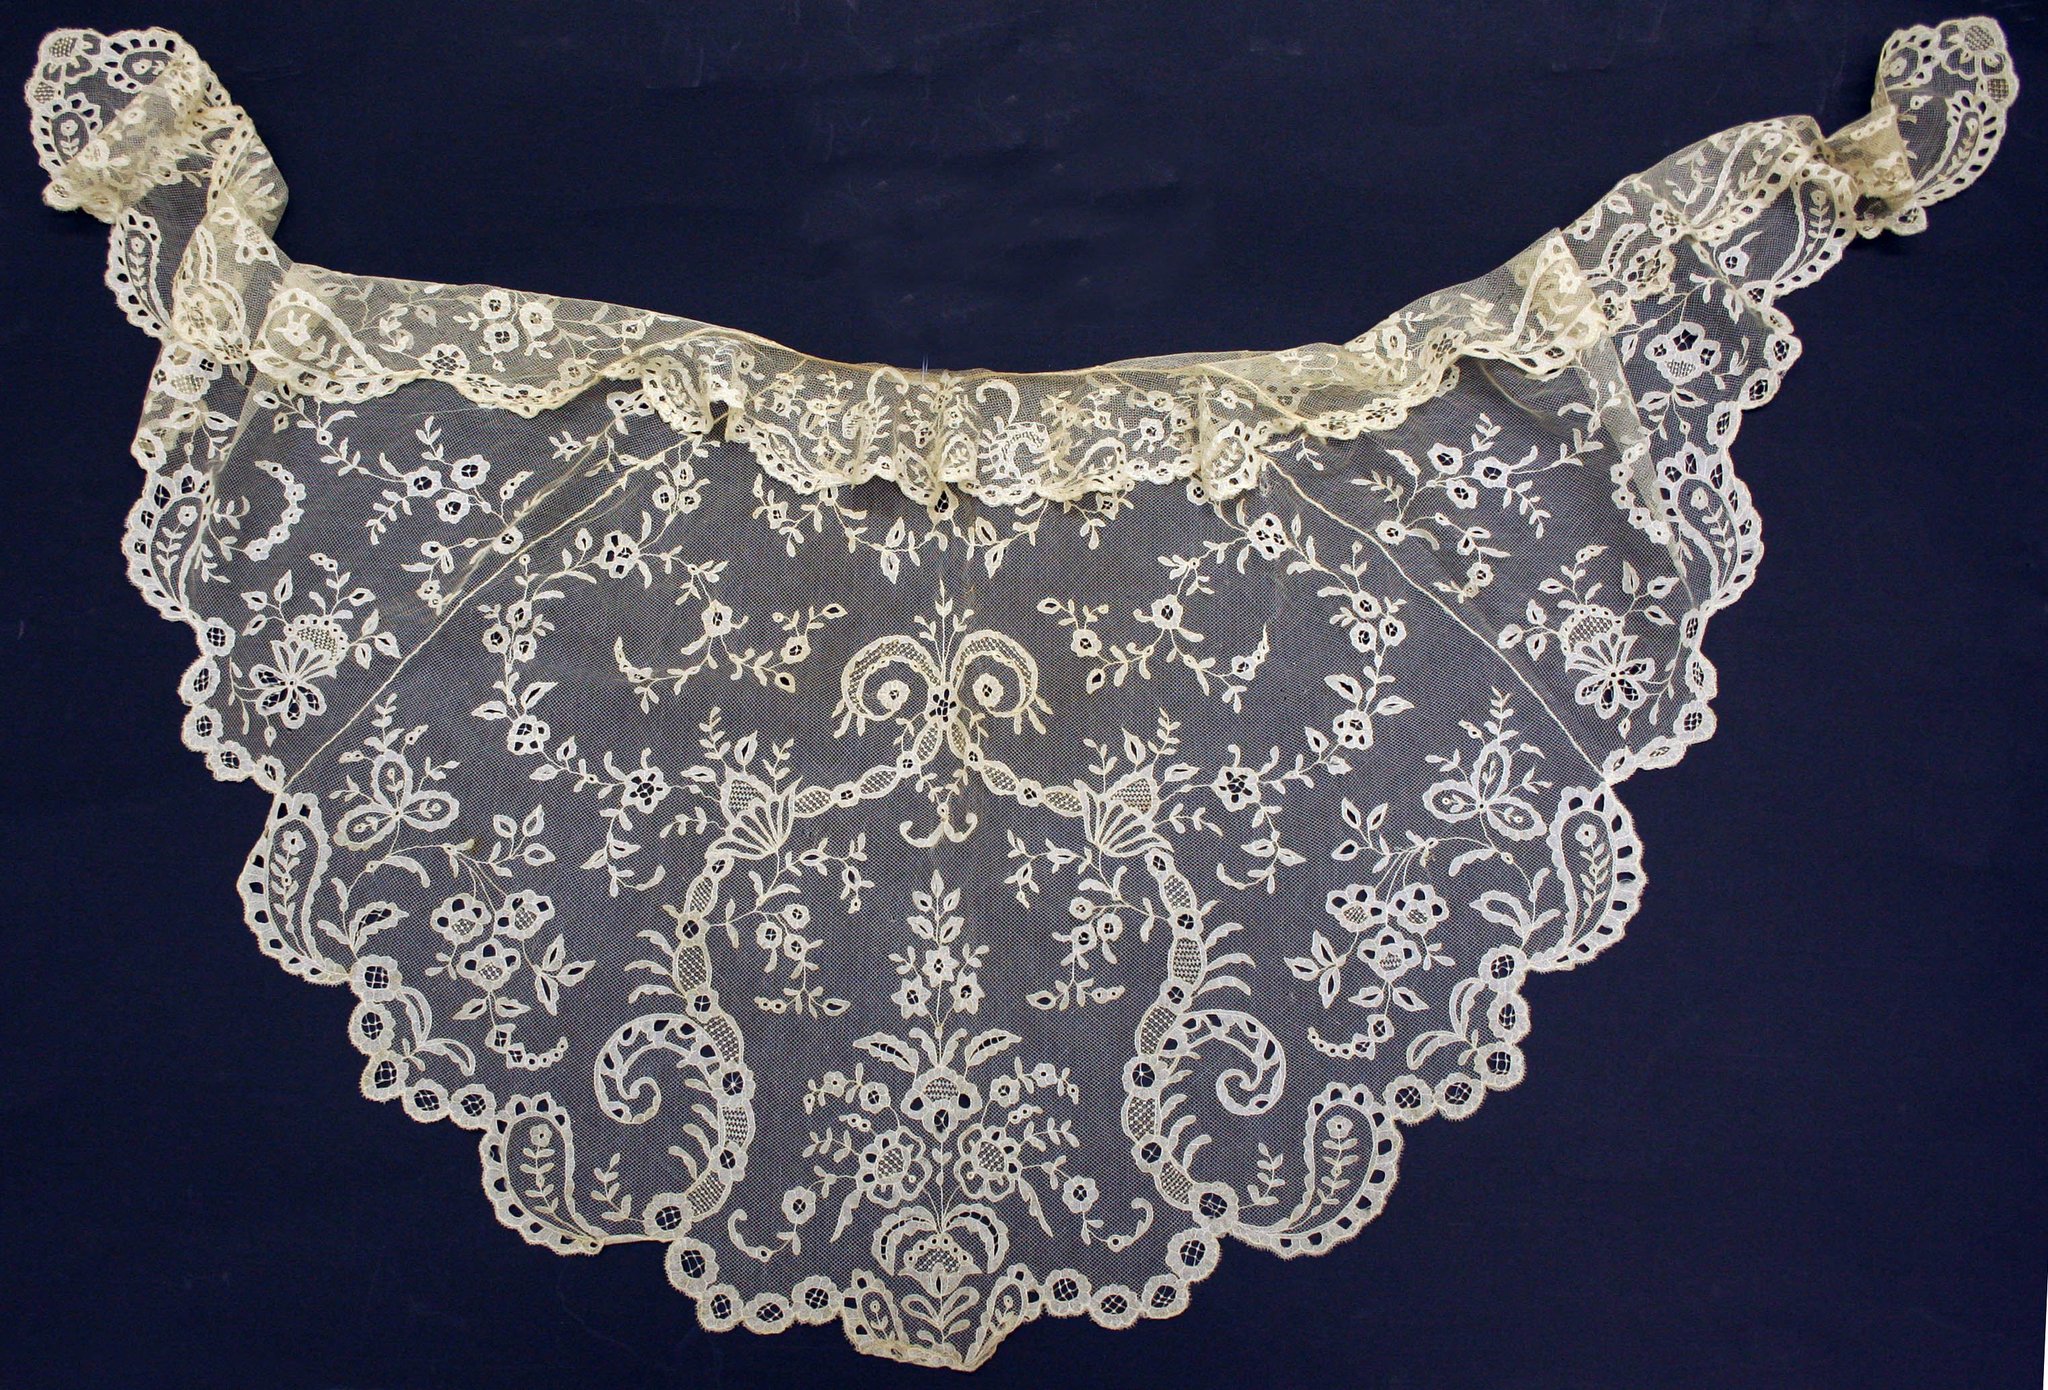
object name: collar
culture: american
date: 1830-1839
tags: flowers